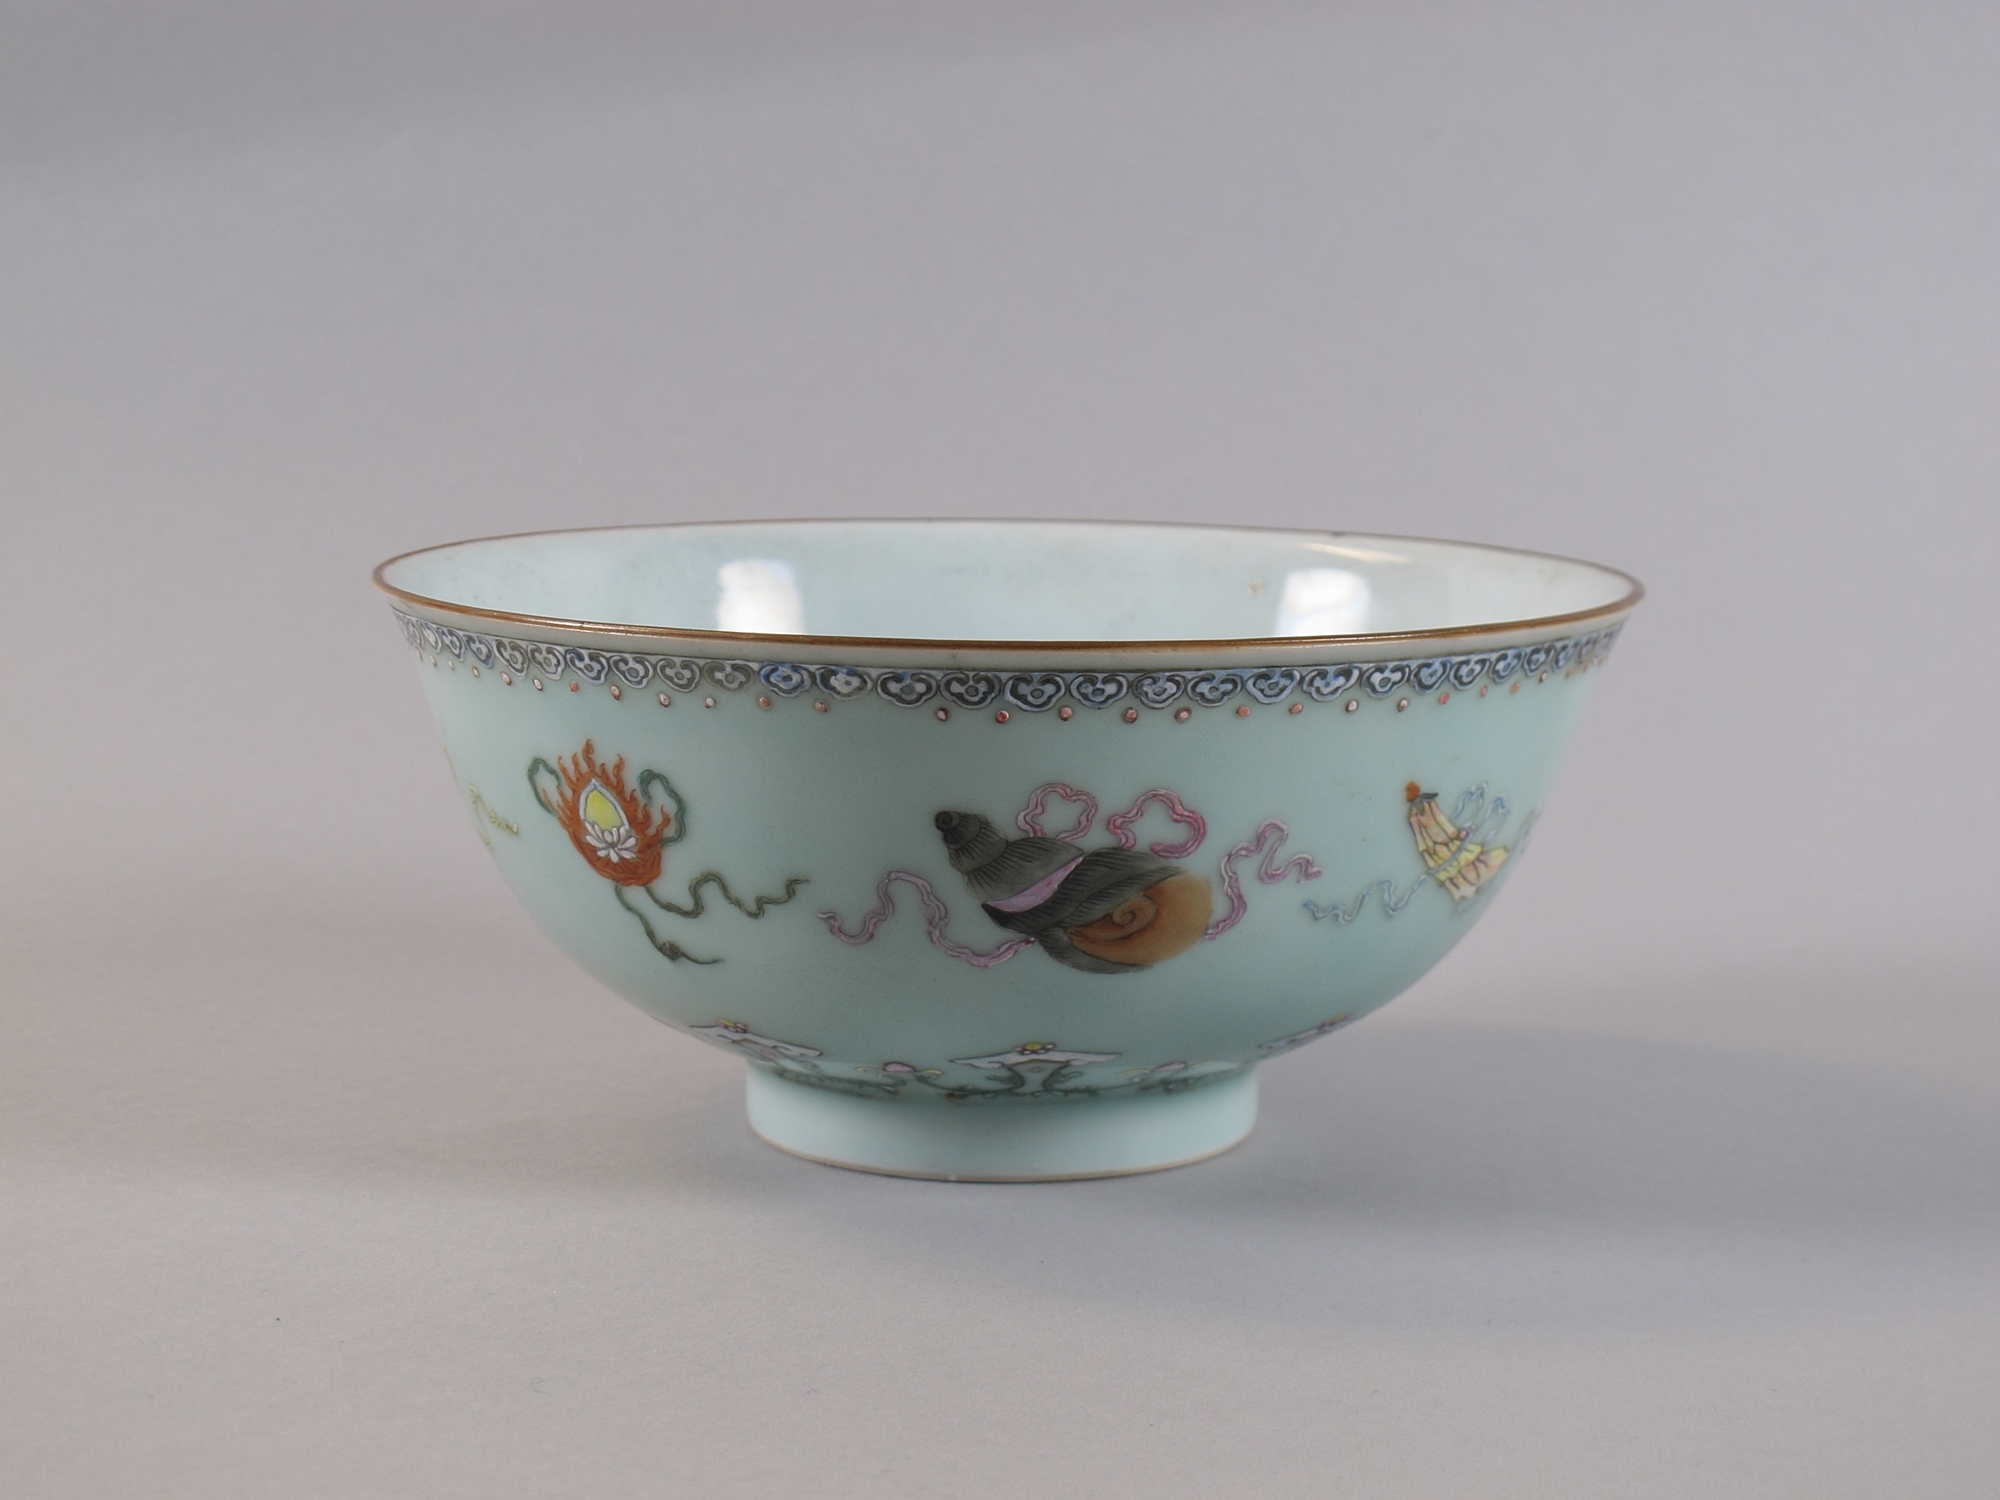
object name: bowl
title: Bowl with eight Buddhist treasures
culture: chinese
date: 1767-1800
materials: ceramic glaze, enamel, glaze, porcelain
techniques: painting, polychrome